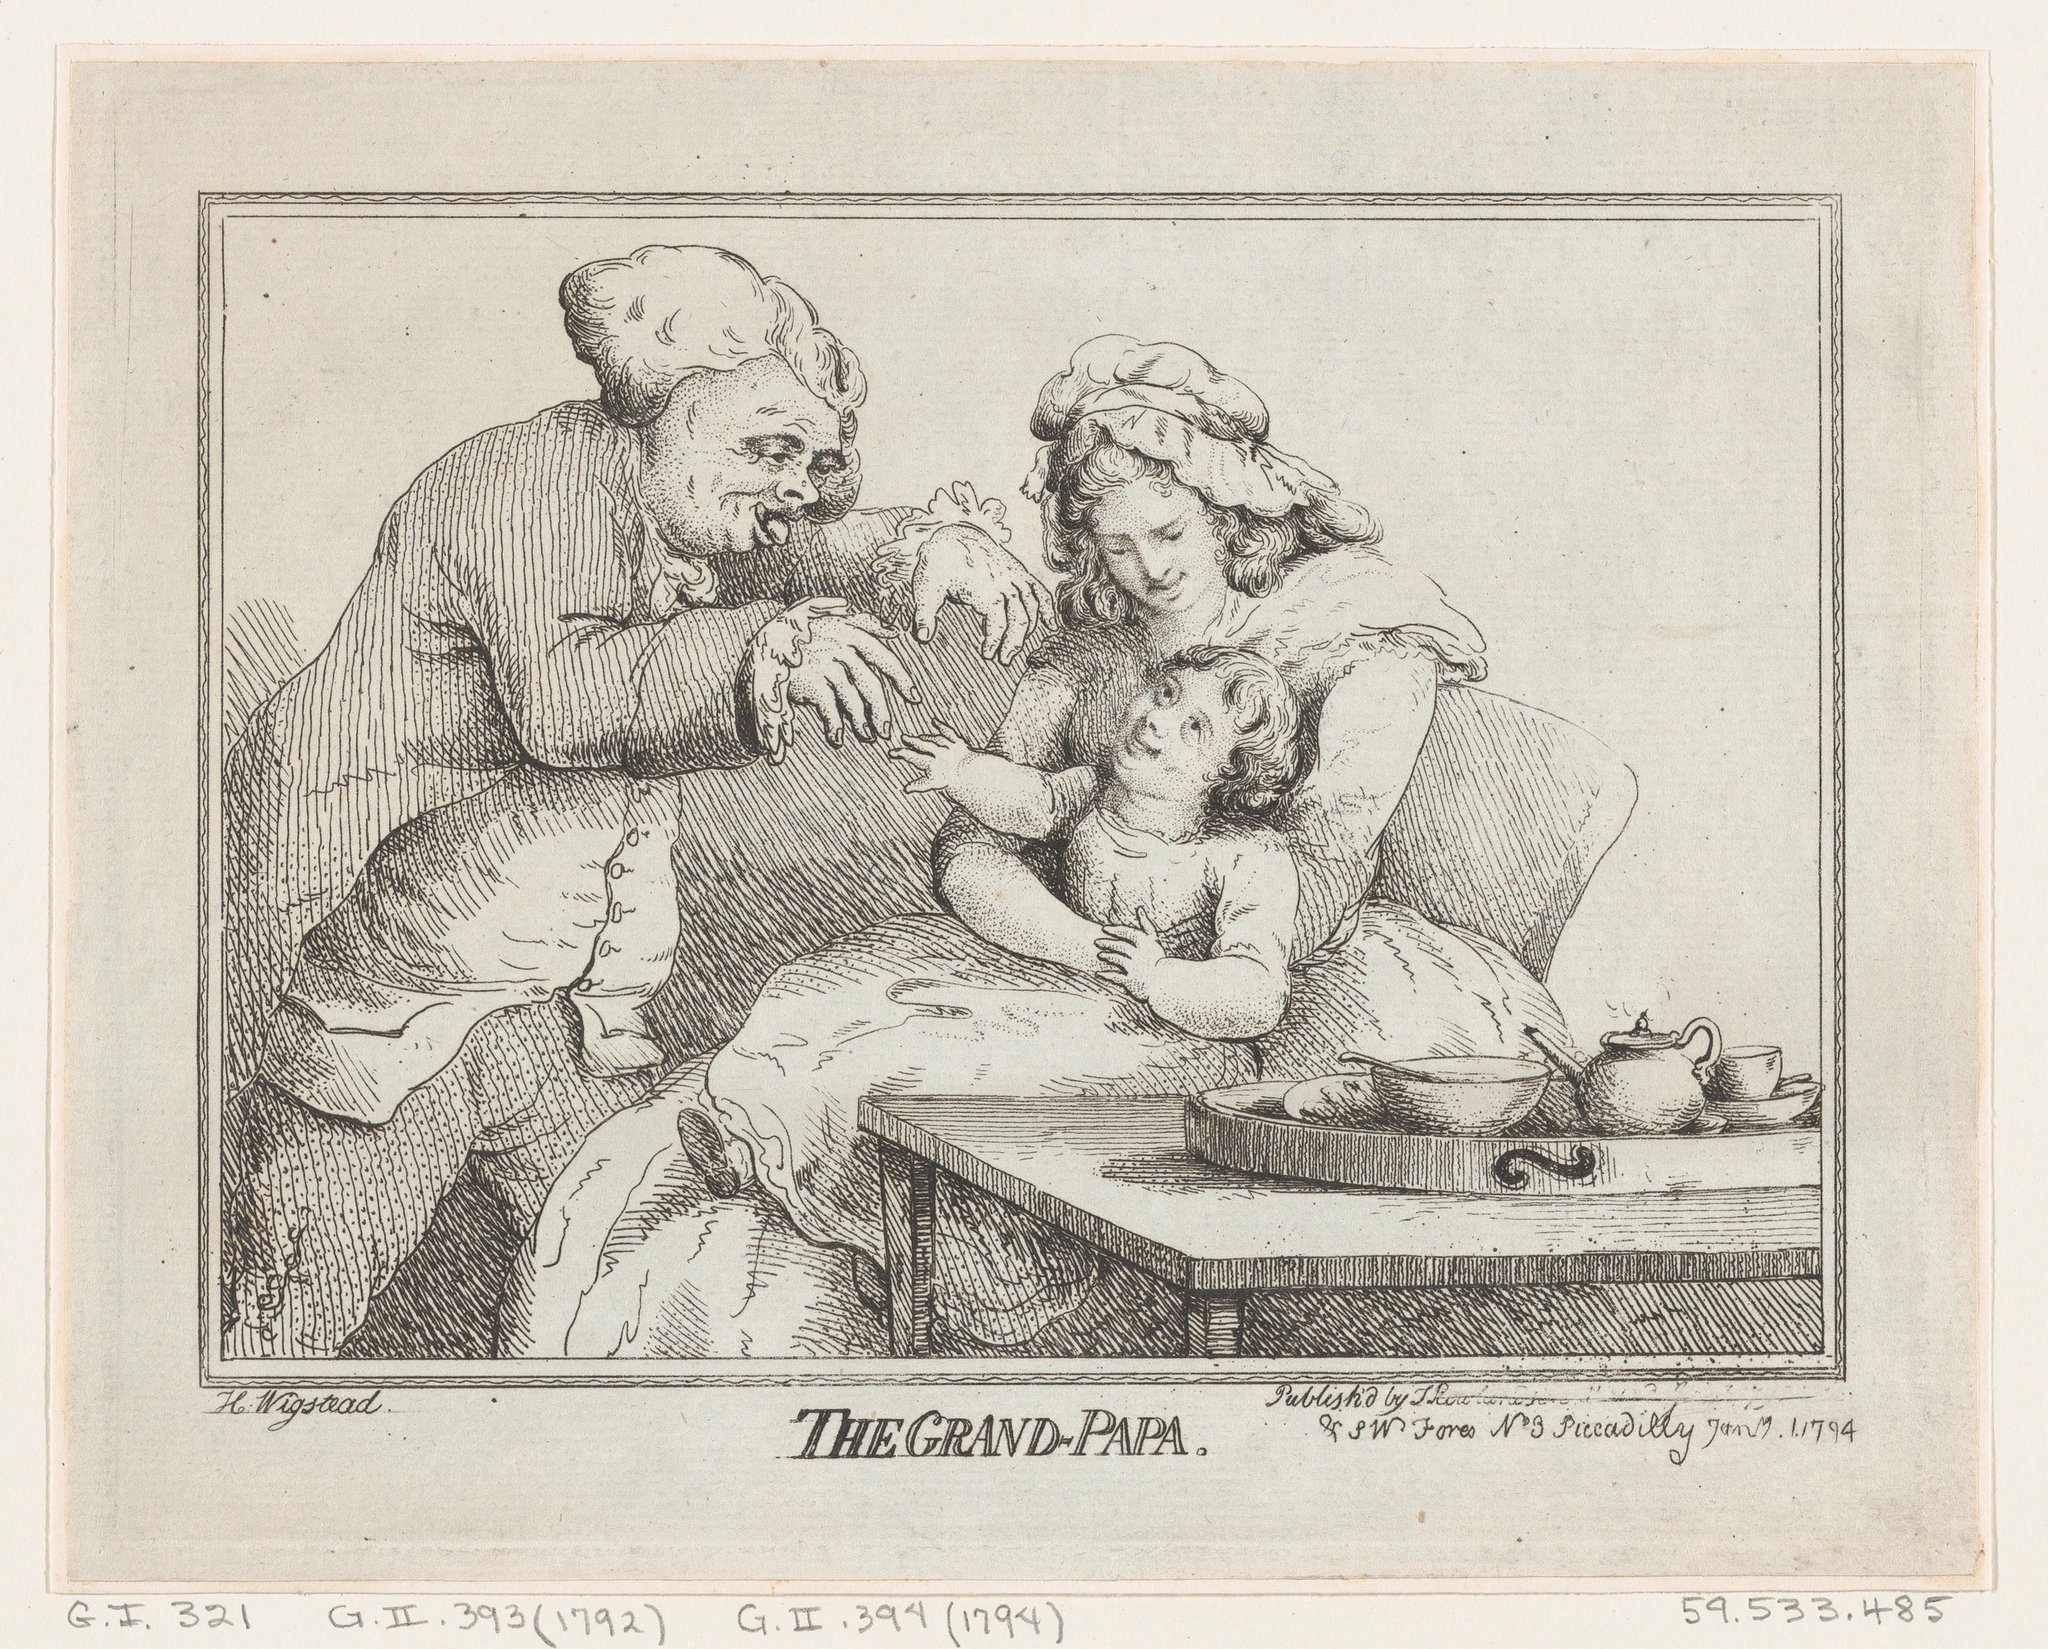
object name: print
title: The Grand-Papa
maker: thomas rowlandson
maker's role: artist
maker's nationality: british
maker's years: 1757-1827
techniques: etching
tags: children,men,women